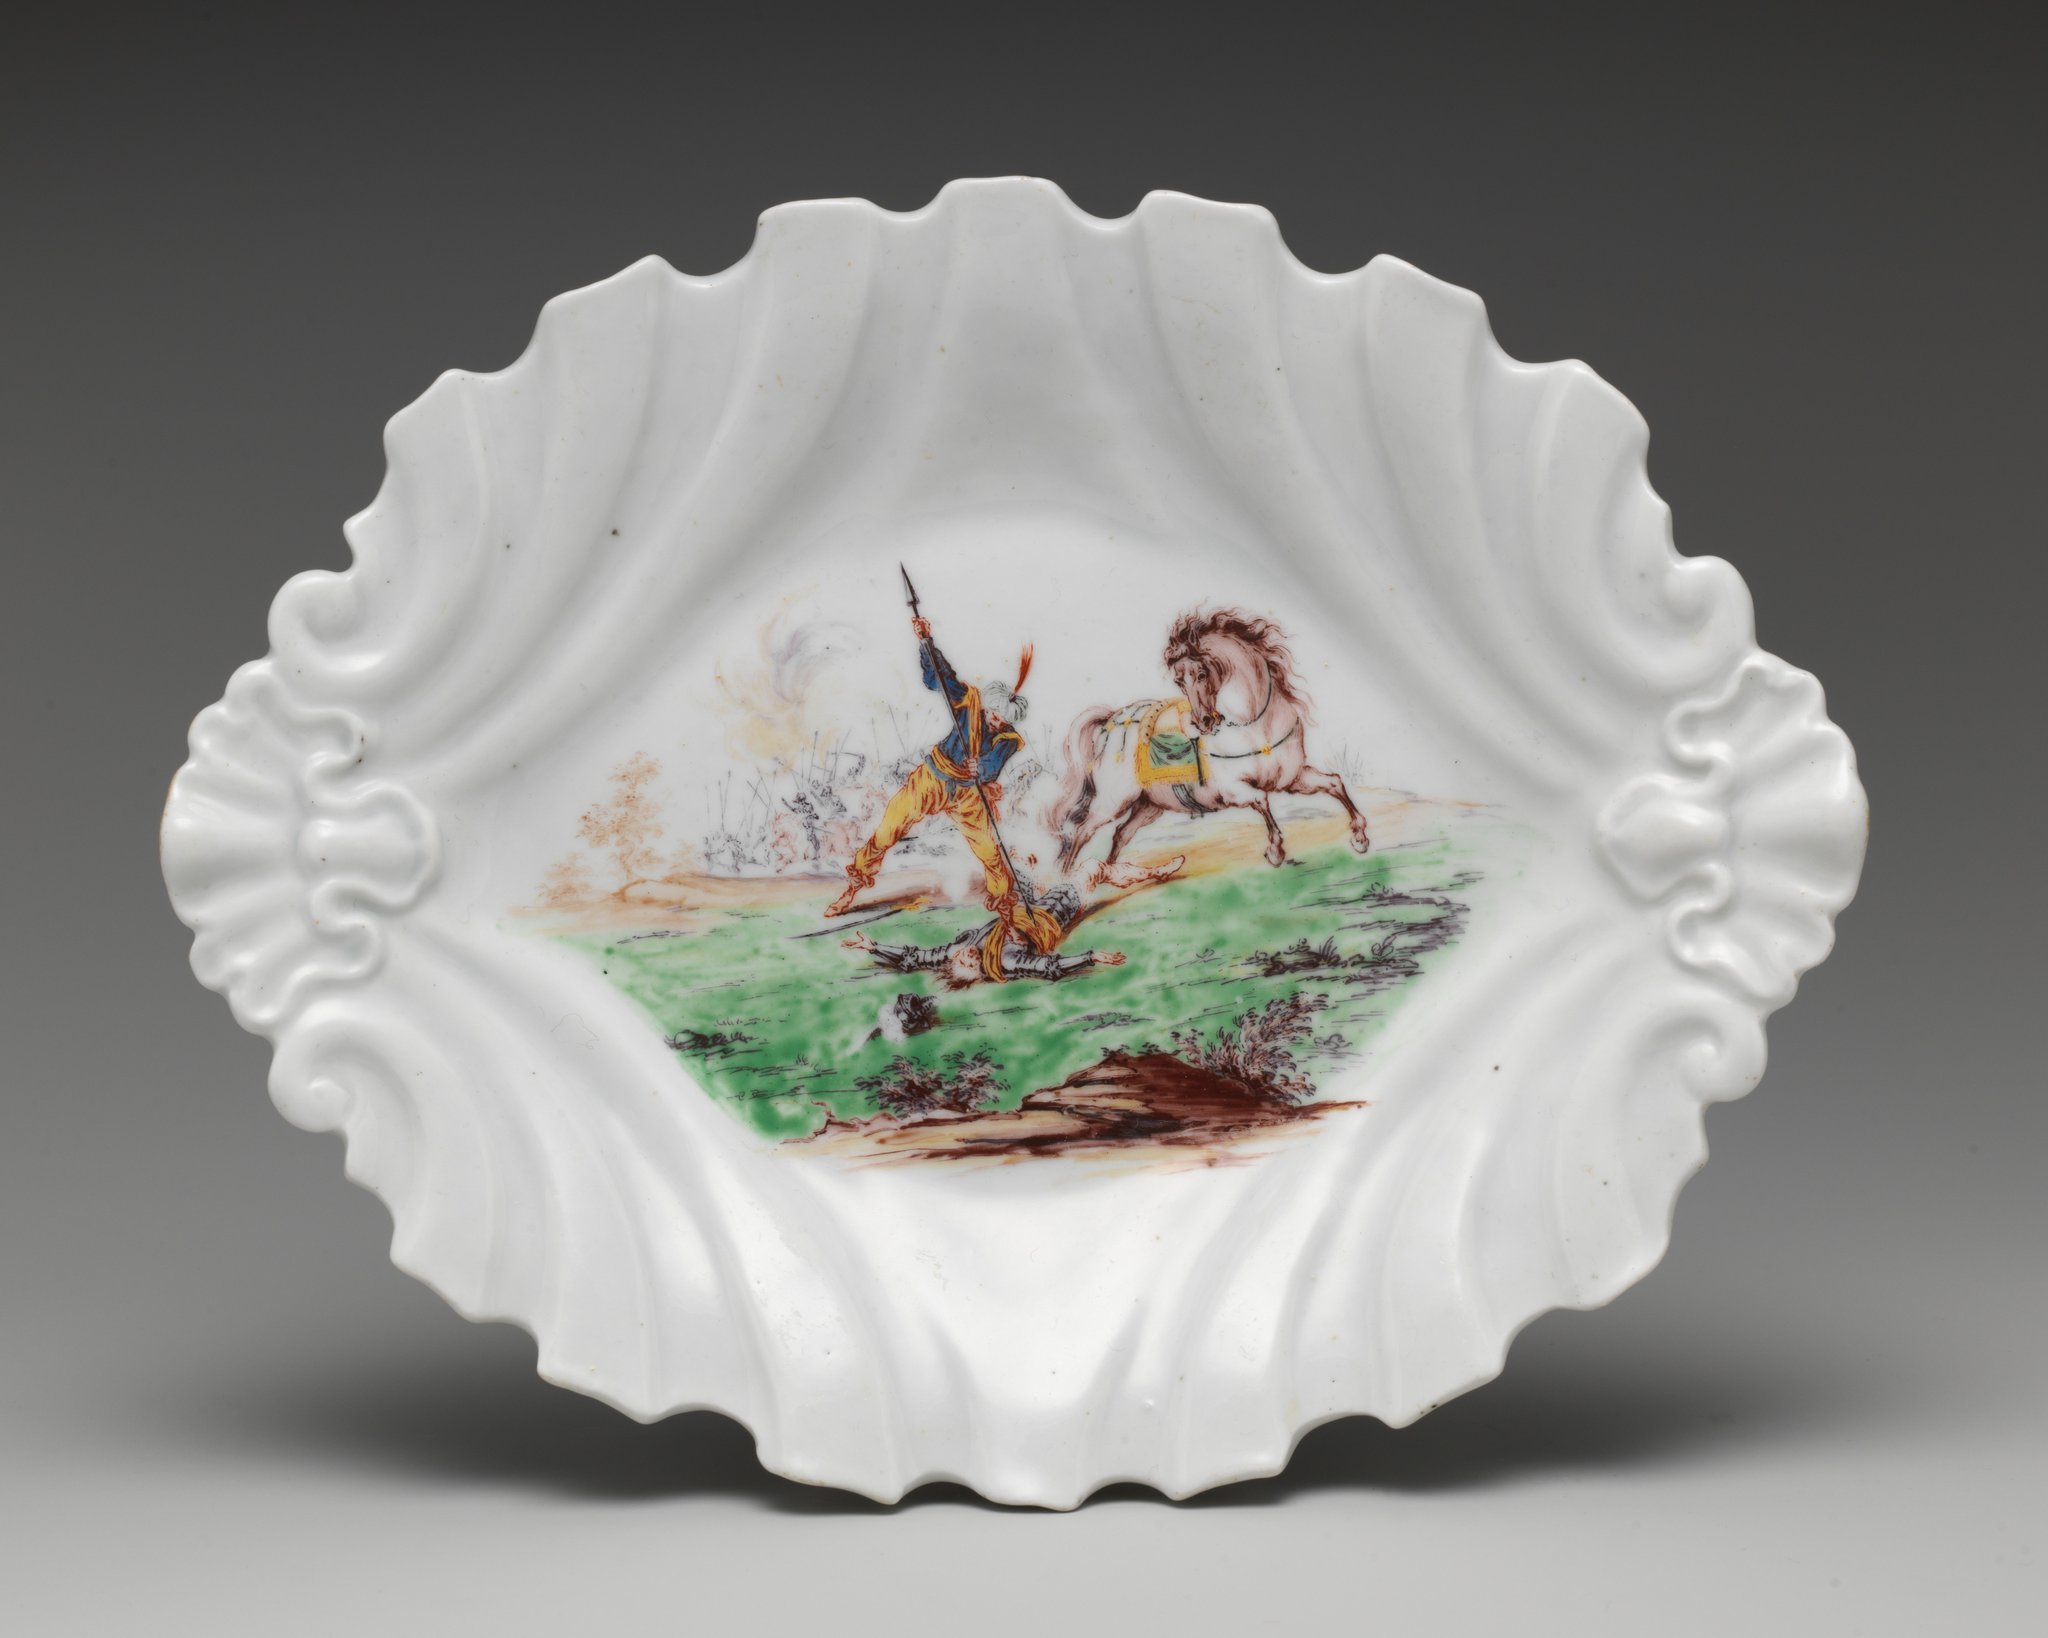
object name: dish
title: Dish (part of a set)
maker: chelsea porcelain manufactory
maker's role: factory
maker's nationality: british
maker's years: 1744-1784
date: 1752-1755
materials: soft paste porcelain